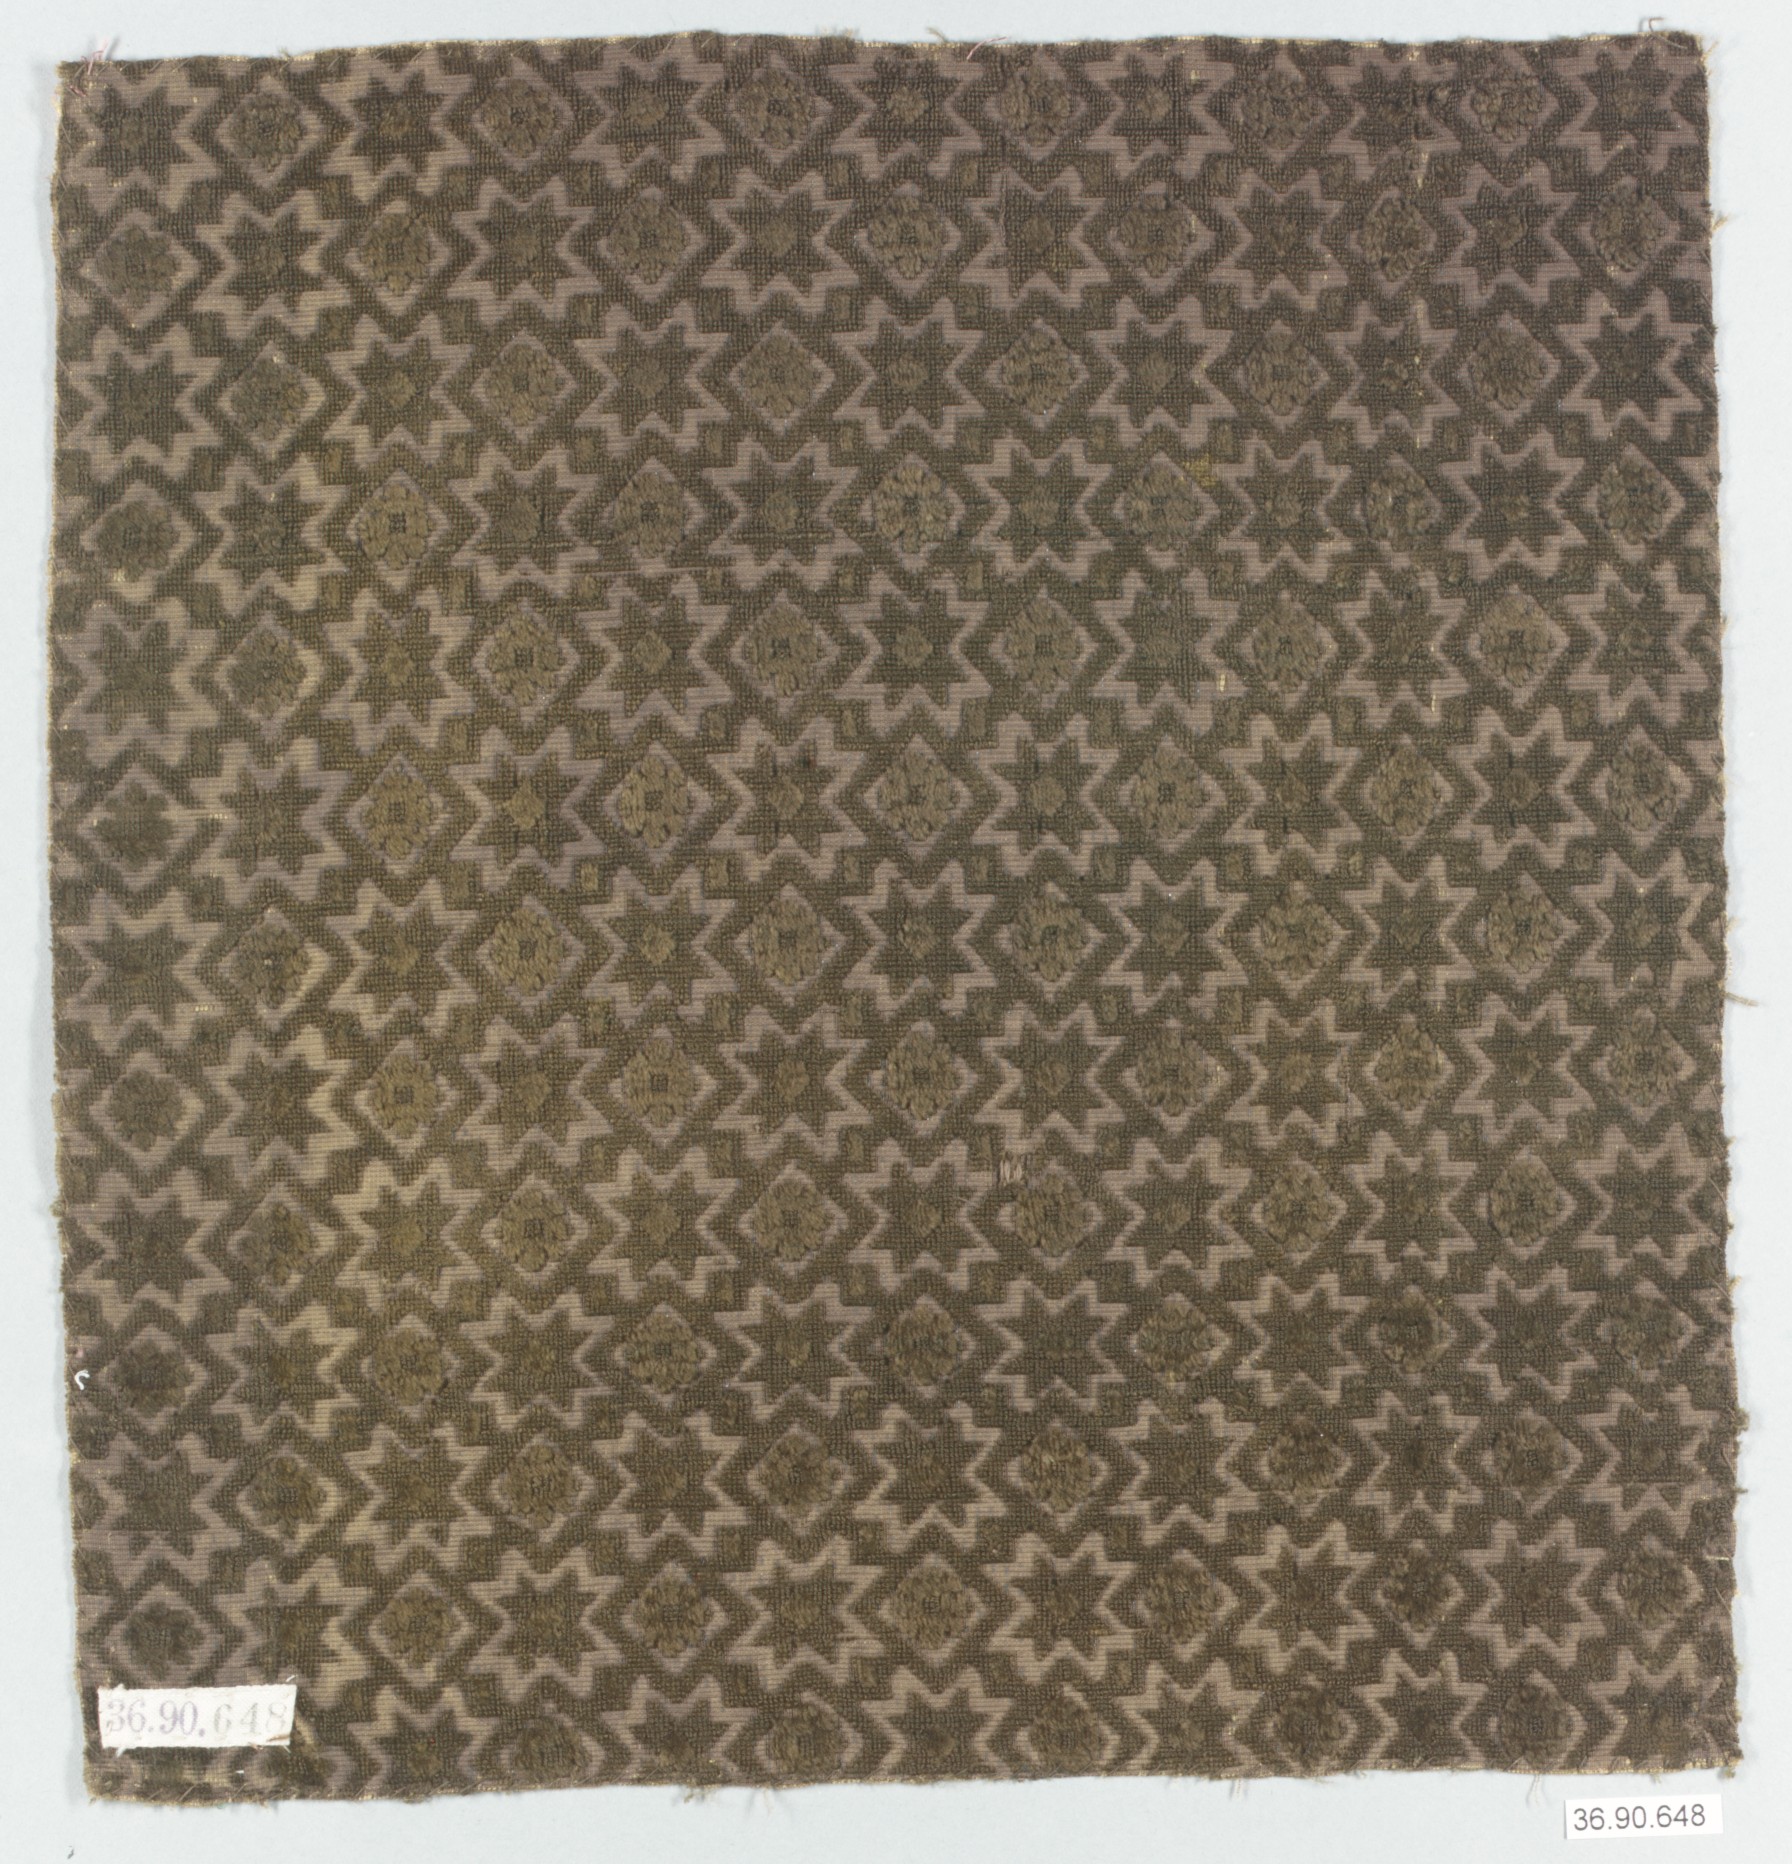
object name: piece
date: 1501-1700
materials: metal thread, silk